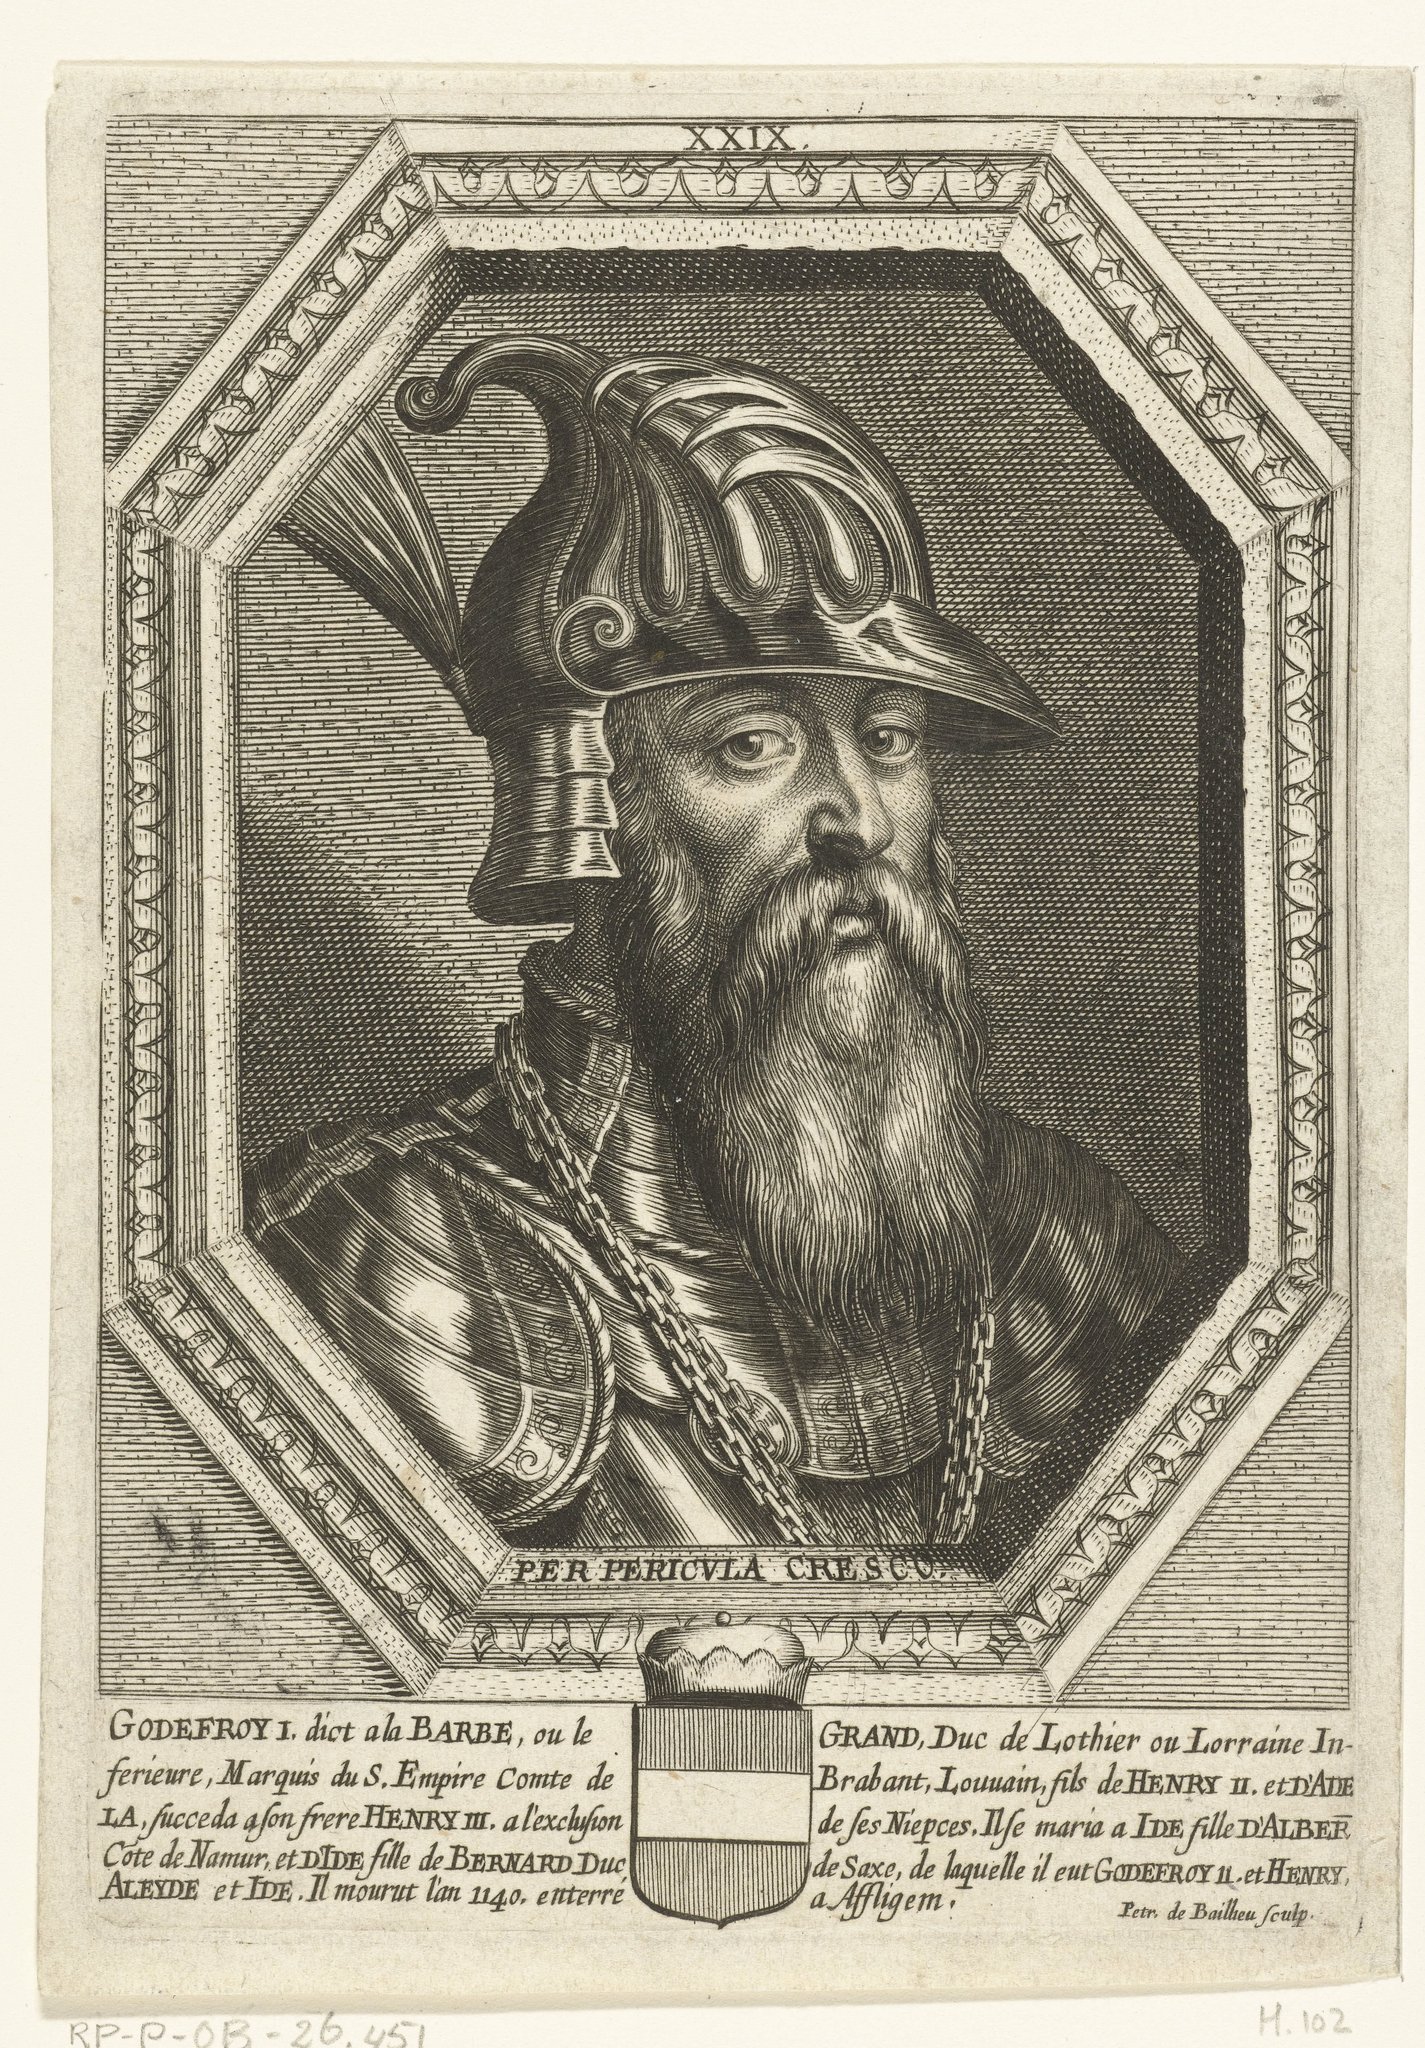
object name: print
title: Portret van graaf Godfried I van Leuven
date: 1623-1660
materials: paper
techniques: engraving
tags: godfried i van leuven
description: Prent gebruikt voor: Les Effigies des Souverains princes et Ducs de Brabant. Joannes Meyssens (uitgever), Antwerpen 1661. De publicatie bevat vierenvijftig portretten waarvan zes door Pieter de Bailliu.